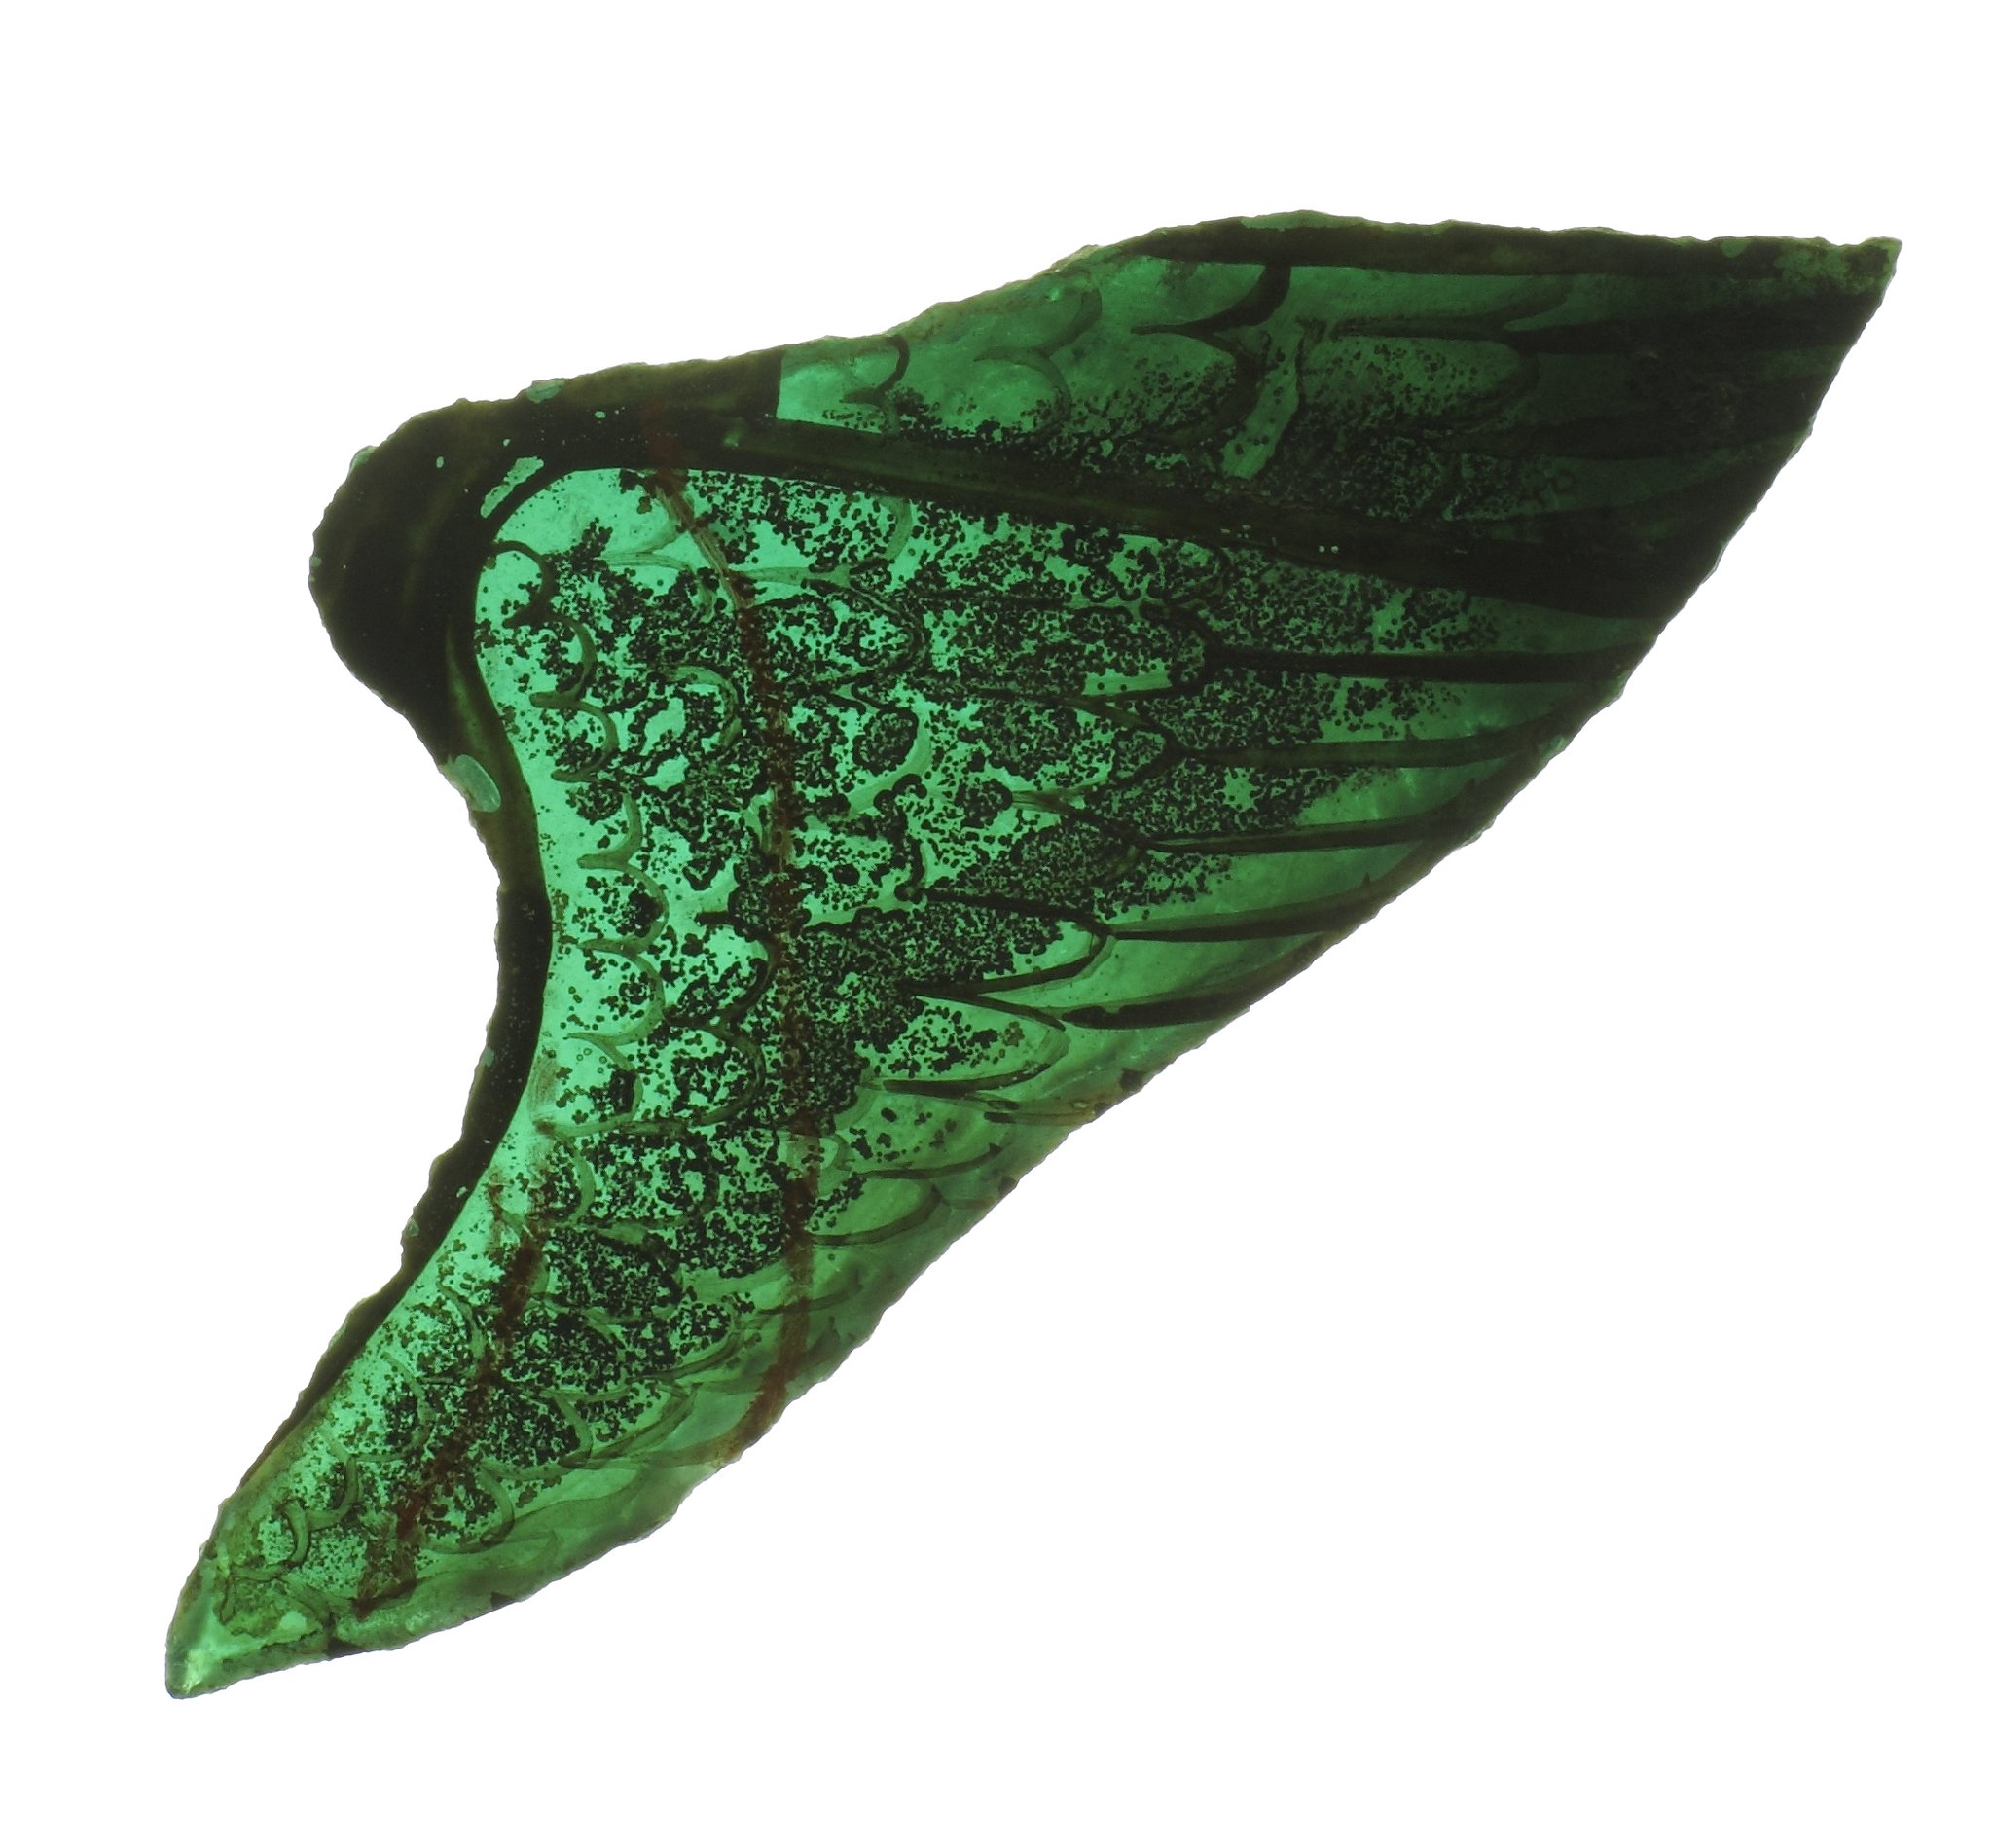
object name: fragment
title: Glass Fragment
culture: french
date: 1101-1400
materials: glass, metal, paint